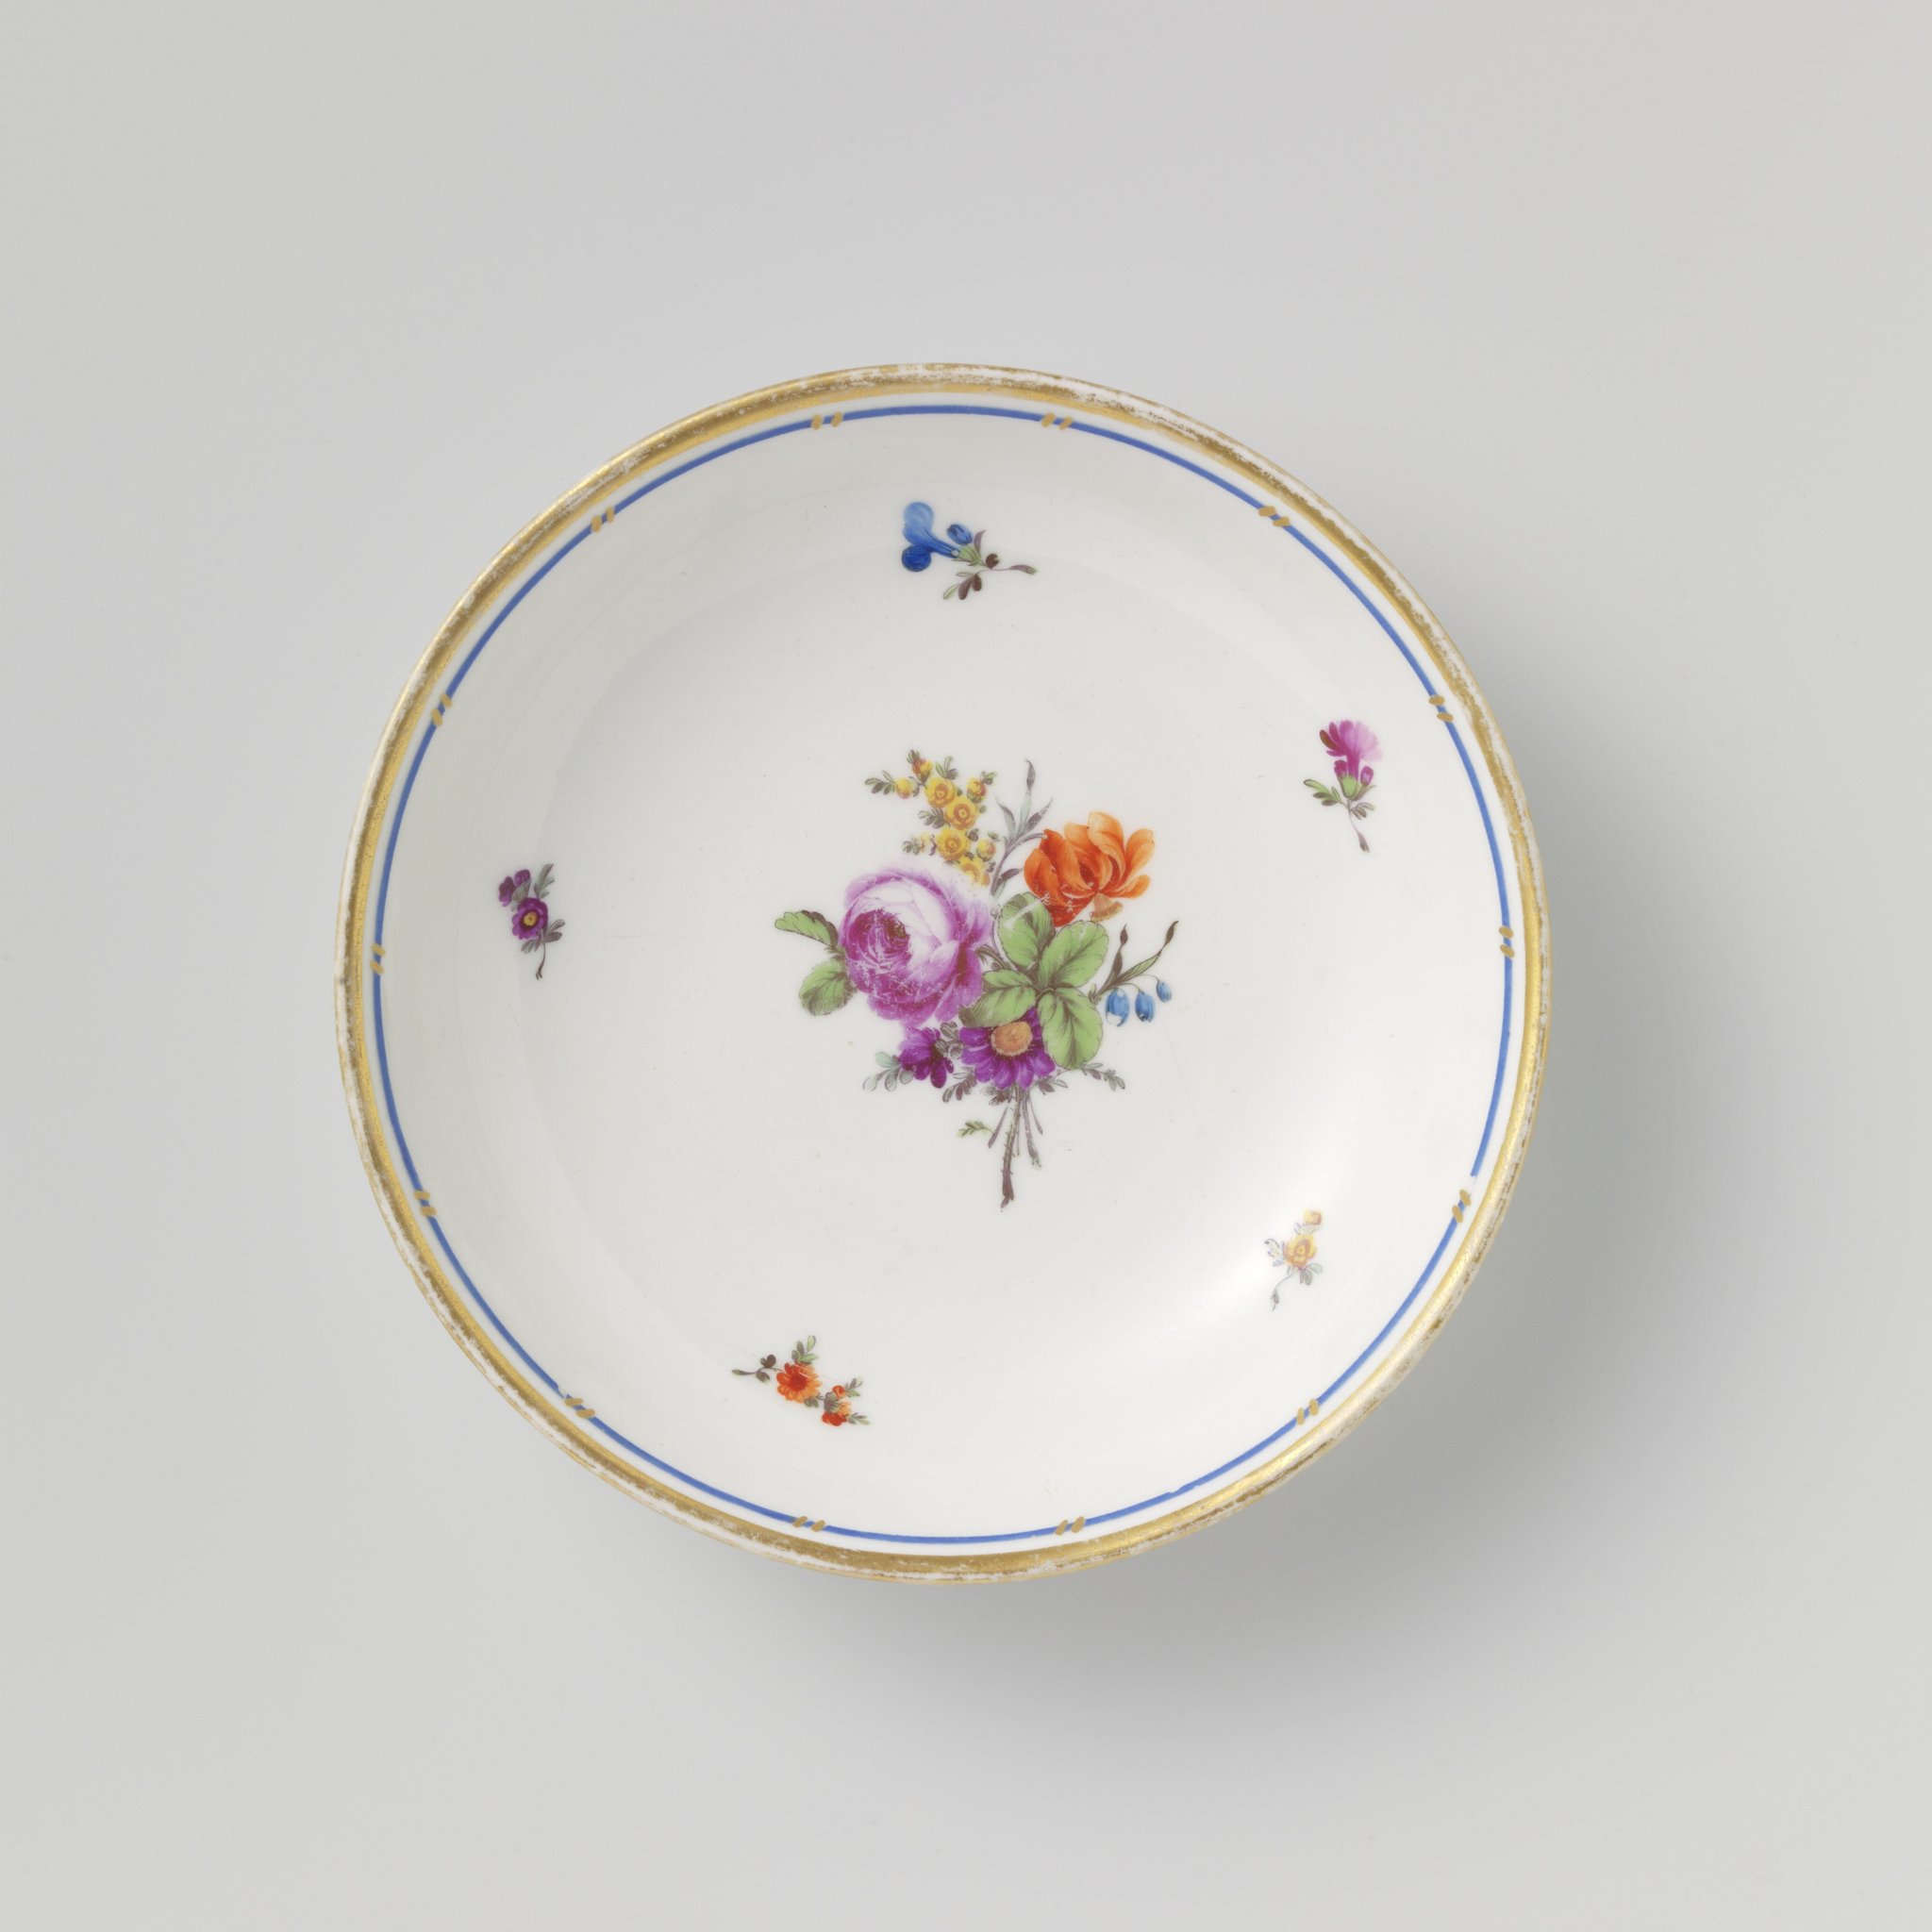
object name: platter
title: Saucer with bouquets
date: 1791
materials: glaze, gold, paint, porcelain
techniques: firing, forming, gilding, turning, vitrification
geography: vienna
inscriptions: mark: ‘schild/ 14, 24’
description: Schotel van porselein, beschilderd op het glazuur in blauw, rood, roze, groen, geel, zwart en goud. Op het plat een boeket van verschillende bloemen omringd door losse bloemtakken. De binnenwand met een blauwe lijn, onderbroken door telkens tweemaal een schuin gouden streepje. Gouden rand. Gemerkt op de onderzijde met het schild, de nummers 24 en 14.